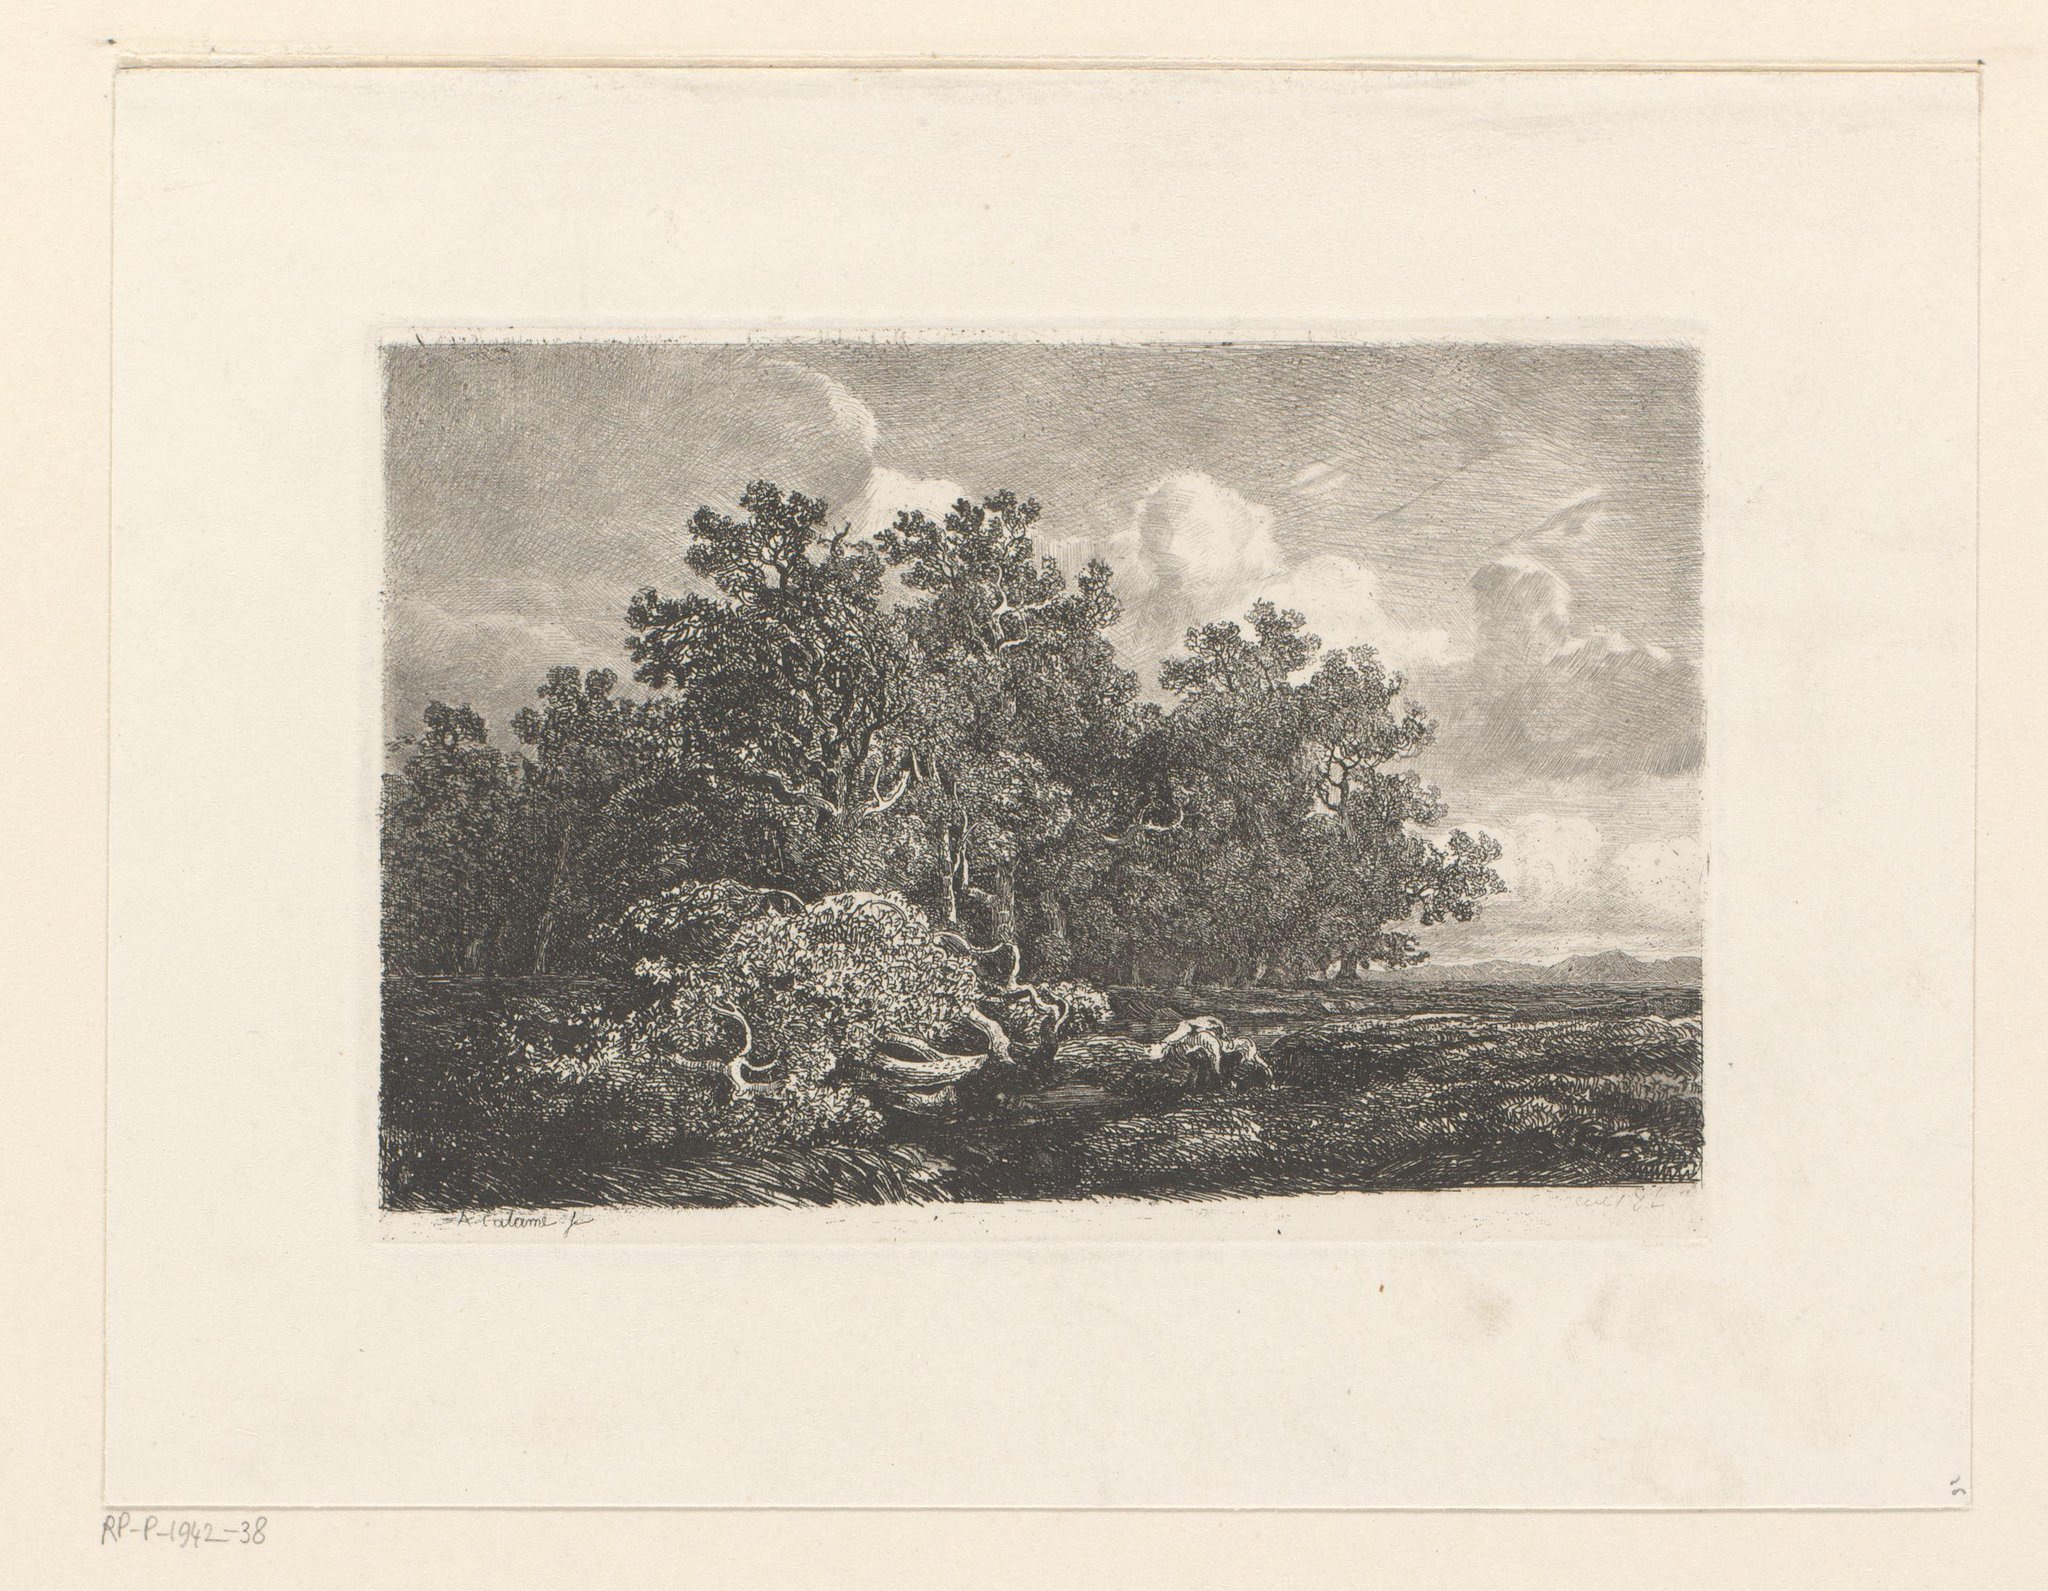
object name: print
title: Essais de gravure a l'eau forte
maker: alexandre calame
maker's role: draughtsman, painter, print maker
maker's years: 1810-1864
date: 1840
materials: paper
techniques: etching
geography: geneva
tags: landscapes, trees: oak (+ dead, withered plant), deciduous forest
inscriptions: collector's mark: Lugt 2760, collector's mark: Lugt 2228